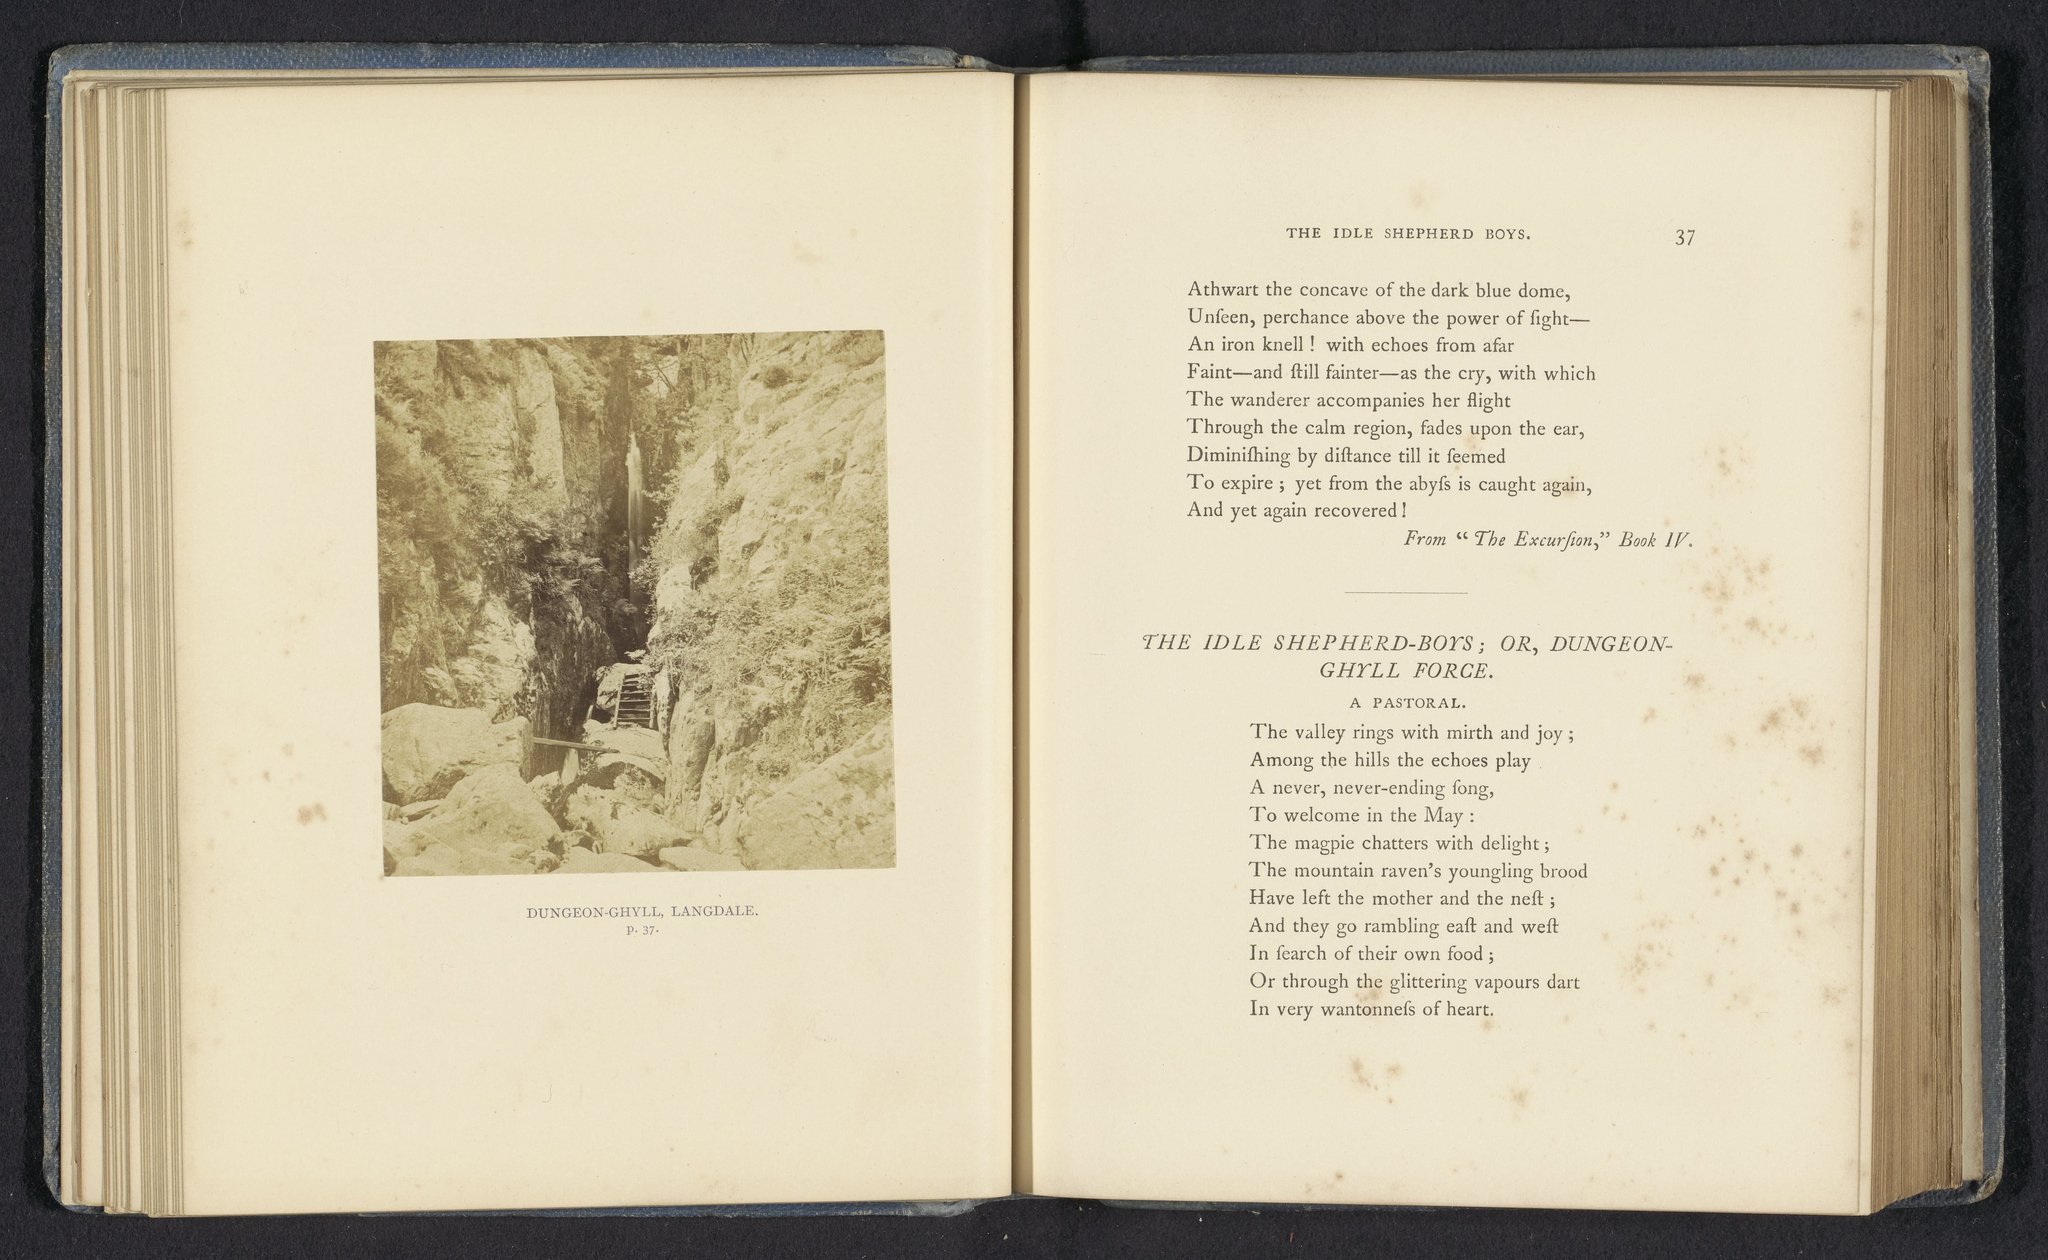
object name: page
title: Dungeon-Ghyll, Langdale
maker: thomas ogle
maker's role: fotograaf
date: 1854-1864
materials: photographic support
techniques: albumen print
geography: lake district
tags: waterfall